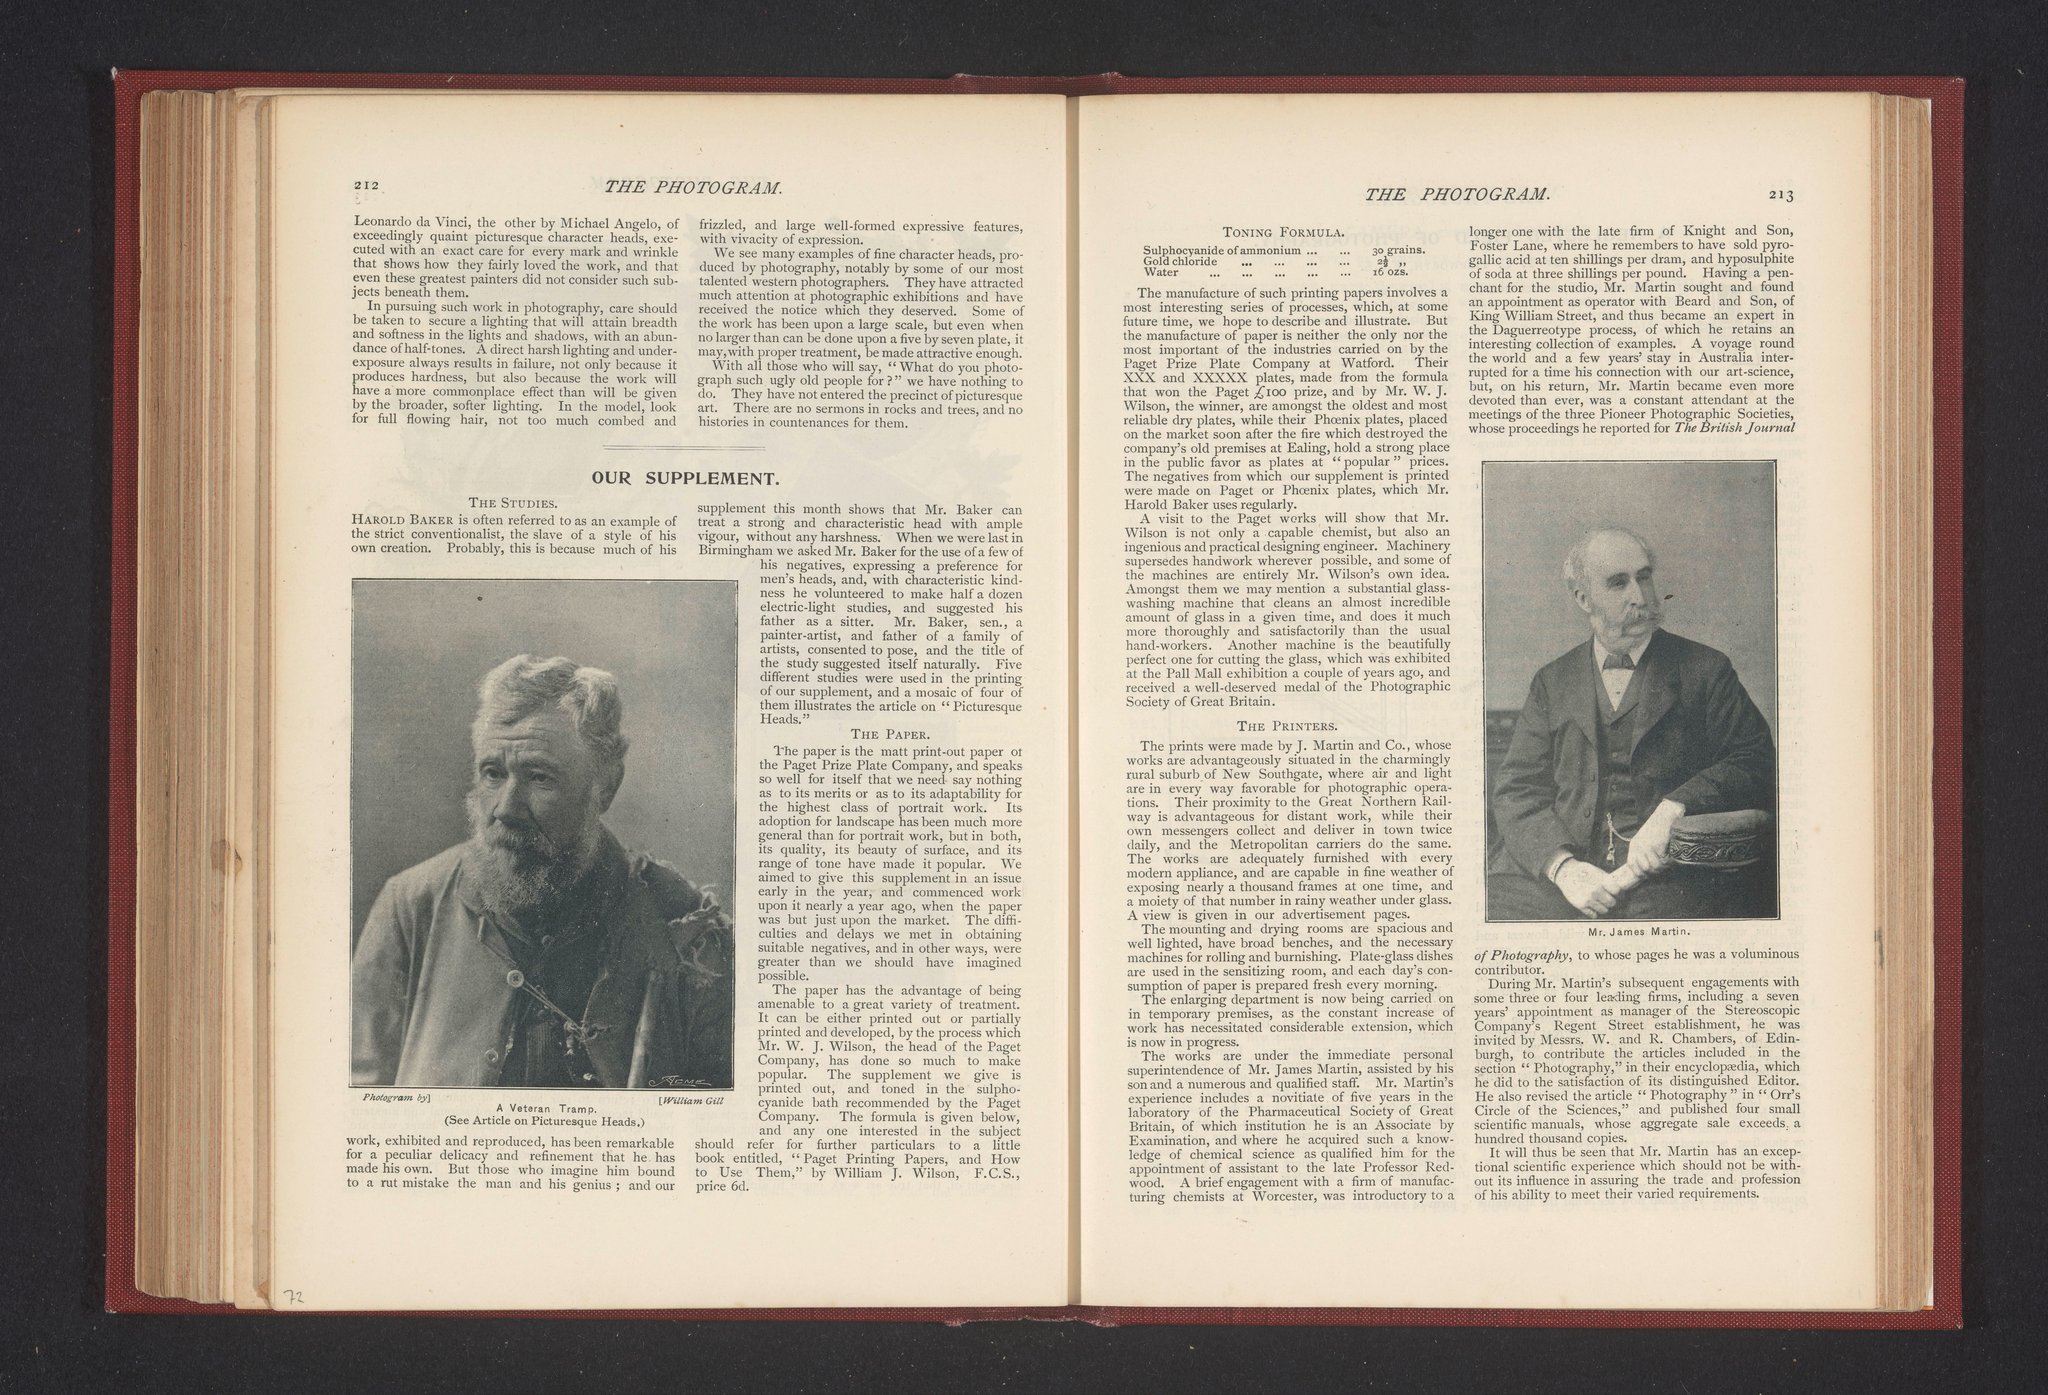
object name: page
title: Portret van een onbekende man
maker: william gill (fotograaf)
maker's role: fotograaf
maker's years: 1854-1912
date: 1889-1894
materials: paper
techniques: autotype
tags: historical persons